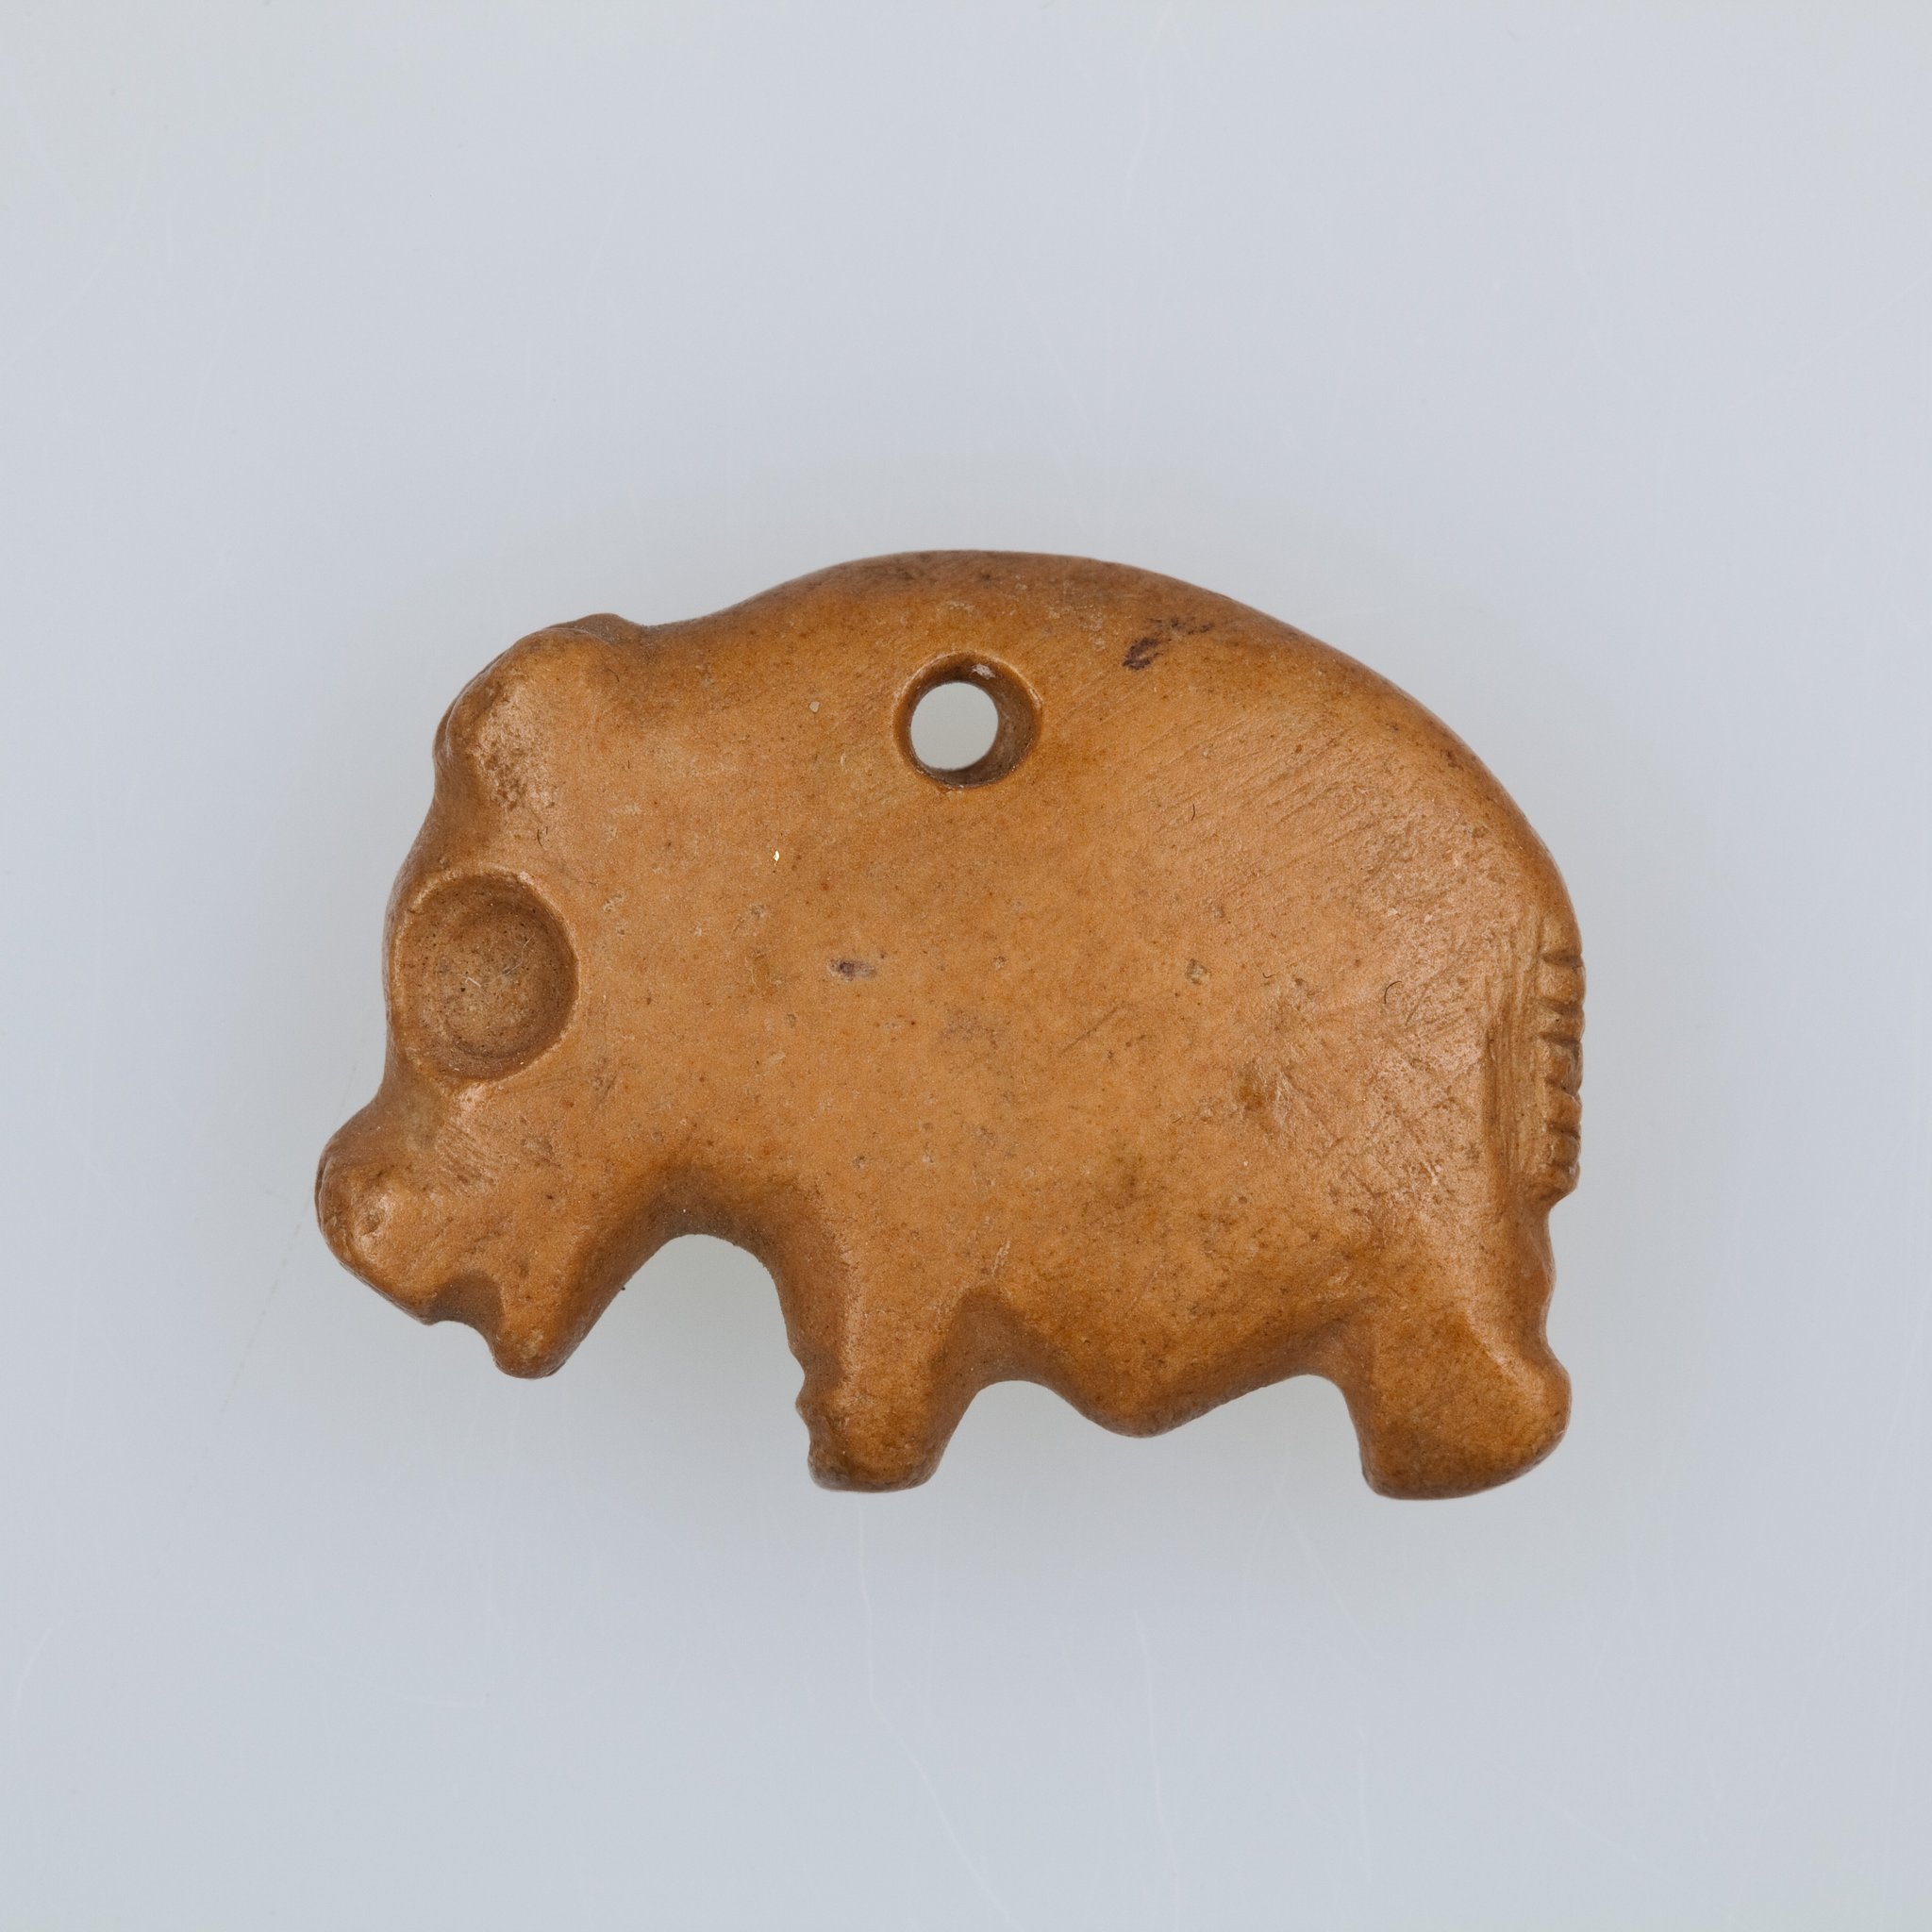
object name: amulet, hippopotamus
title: Amulet in the form of a hippo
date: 3650-3100 BCE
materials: limestone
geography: egypt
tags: hippos